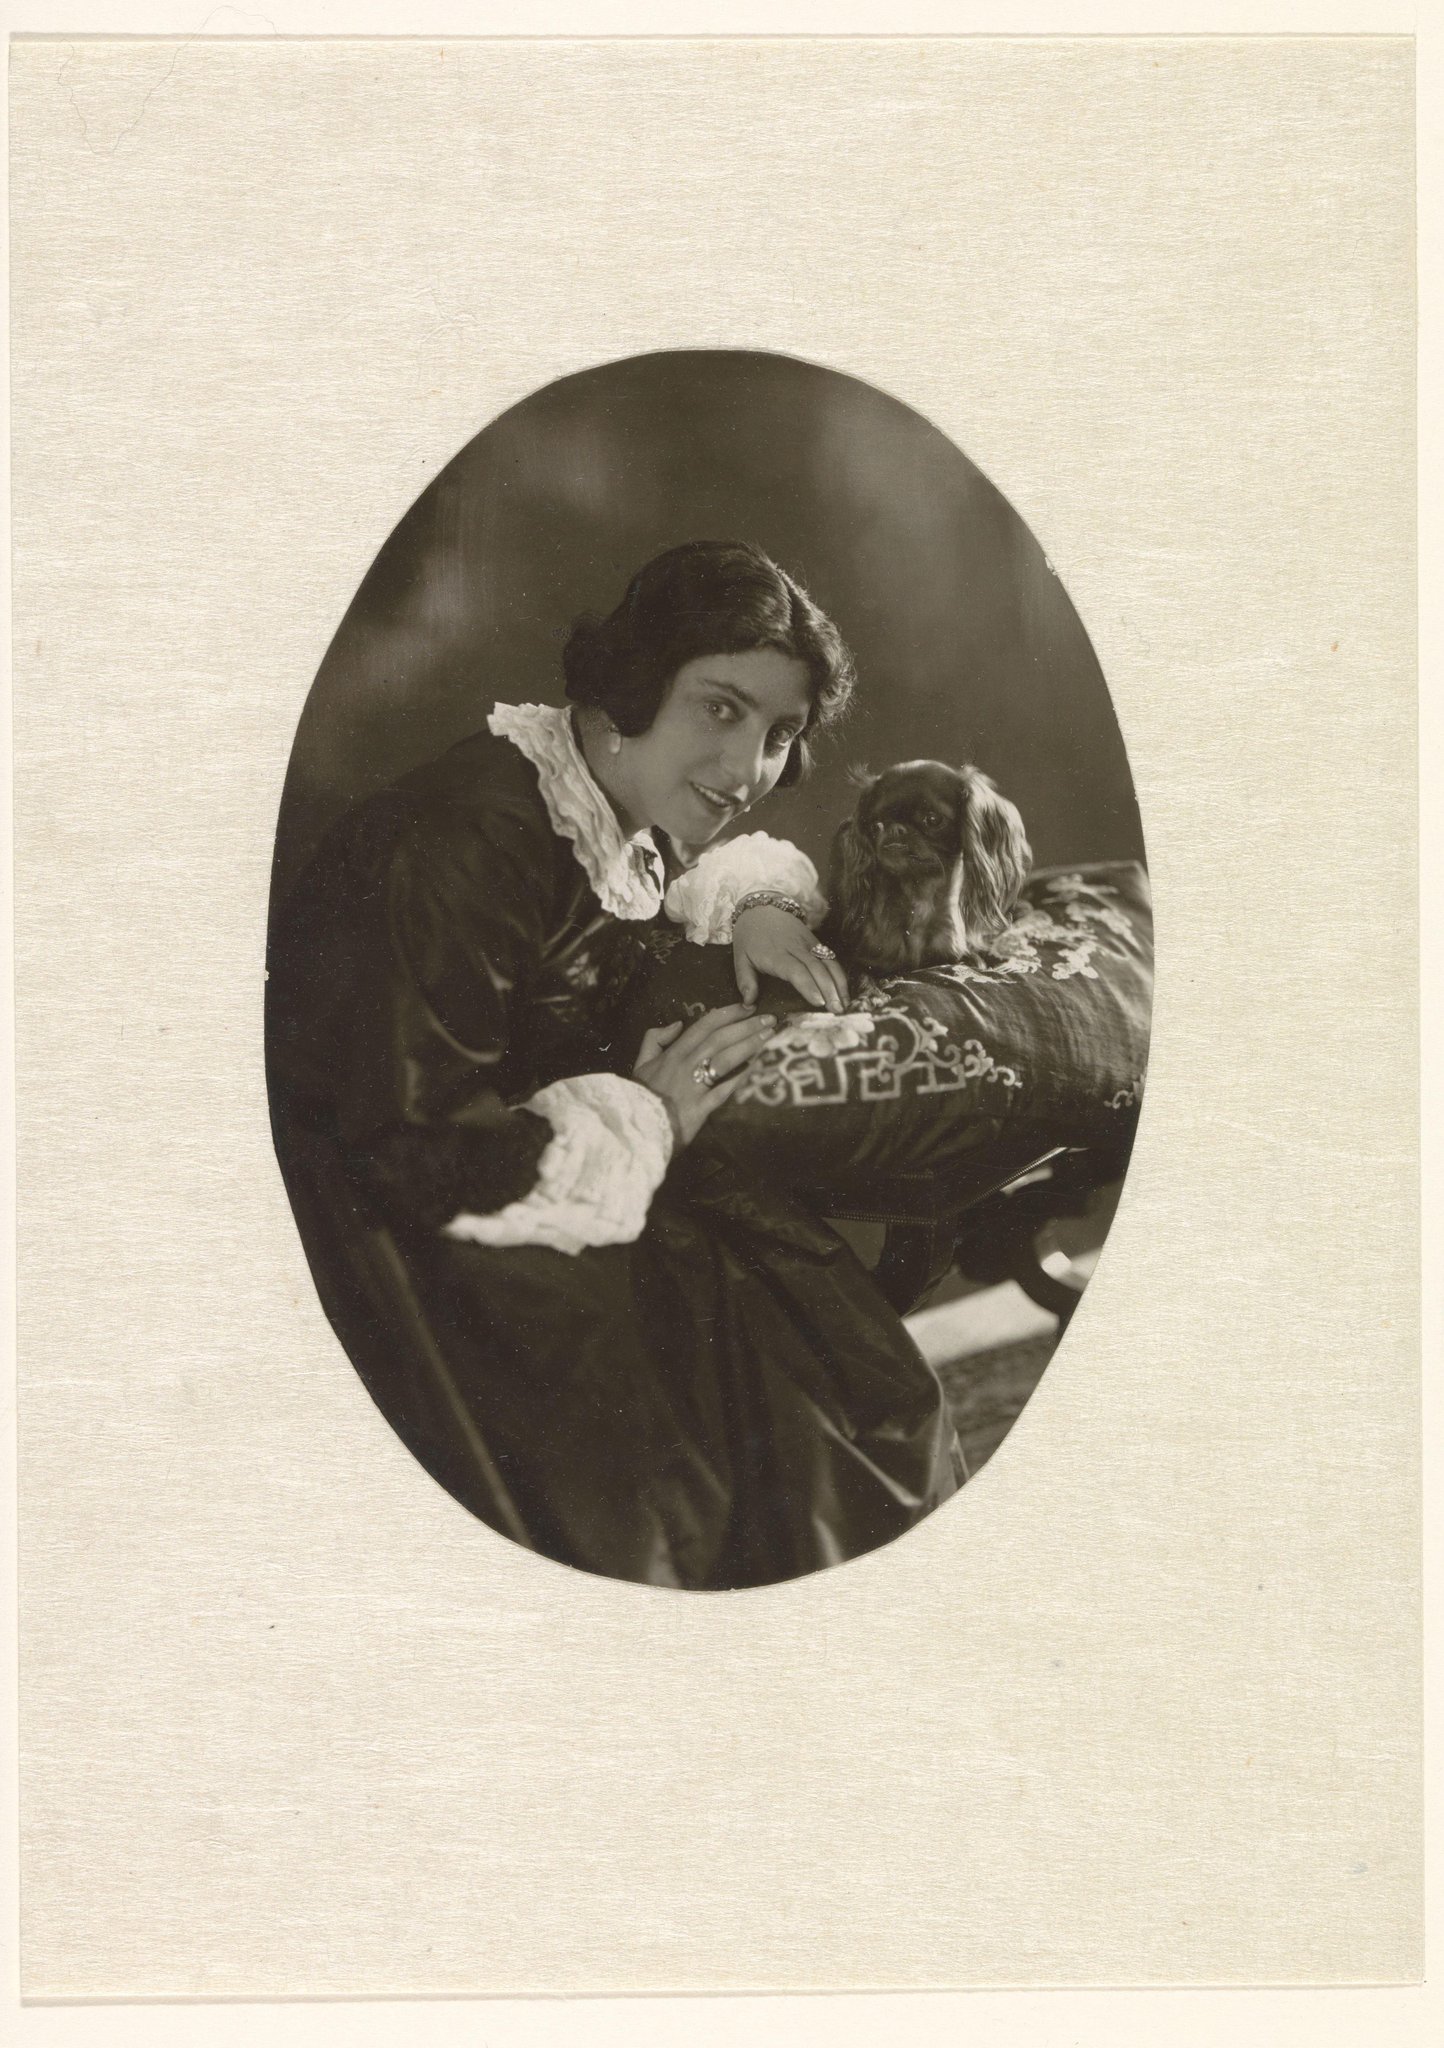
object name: photograph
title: Ovaal studioportret van Jula Rillo, actrice van de Fritz Hirsch operette, met hondje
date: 1929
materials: paper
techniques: gelatin silver print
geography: the hague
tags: historical persons - bb - woman, portrait of actor, actress, dog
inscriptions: stamp: ‘Foto atelier Frans Hals’, annotation: ‘Julia Rillo, actrice Fritz Hirsch operette (Madchen in Frau Lynar's) Friederuco Sommerfortspiele 1925’